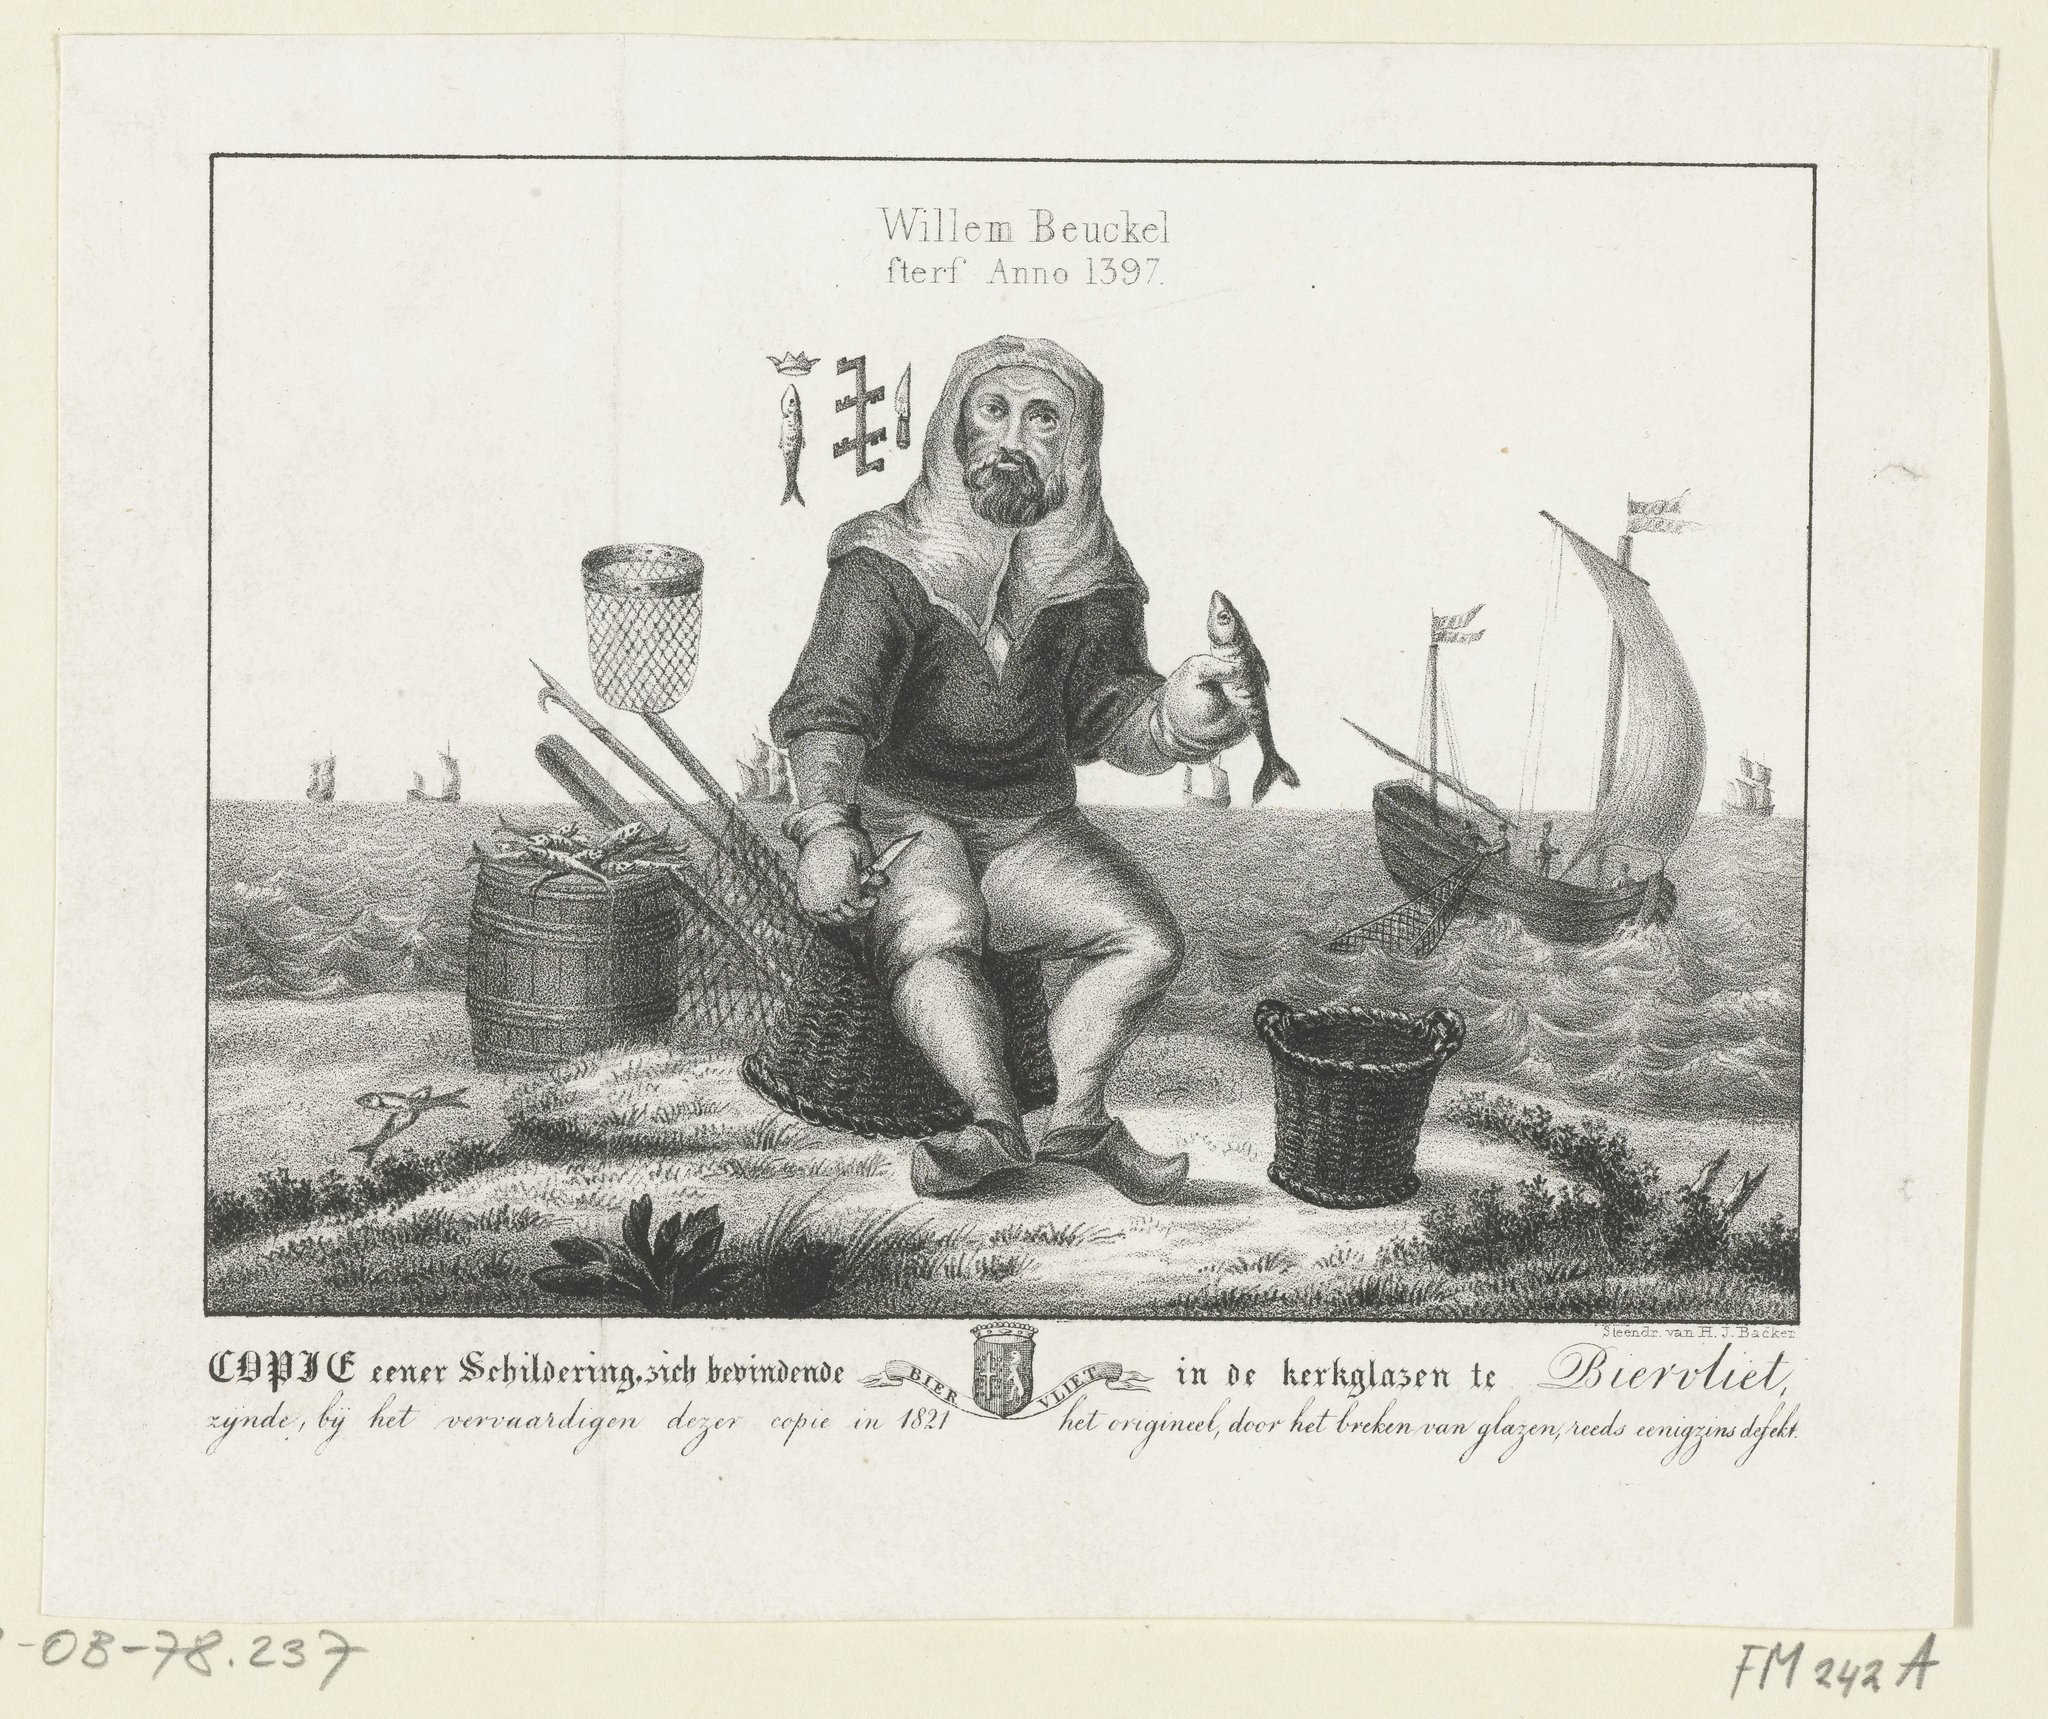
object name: print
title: Willem Beukelszoon, uitvinder van het haringkaken, ca. 1380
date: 1821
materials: paper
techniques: lithograph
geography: netherlands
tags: sea and coastal fishery, burgundian netherlands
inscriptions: date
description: Schildering in de kerkglazen te Biervliet voorstellende Willem Beuckelsz. die ca. 1380 het haringkaken uitgevonden zou hebben. Beukelszoon zit op een omgekeerde mand, een haring in een hand, een mes in een ander. Op de achtergrond vissende boten op zee. Boven: Willem Beukel sterf Anno 1397.